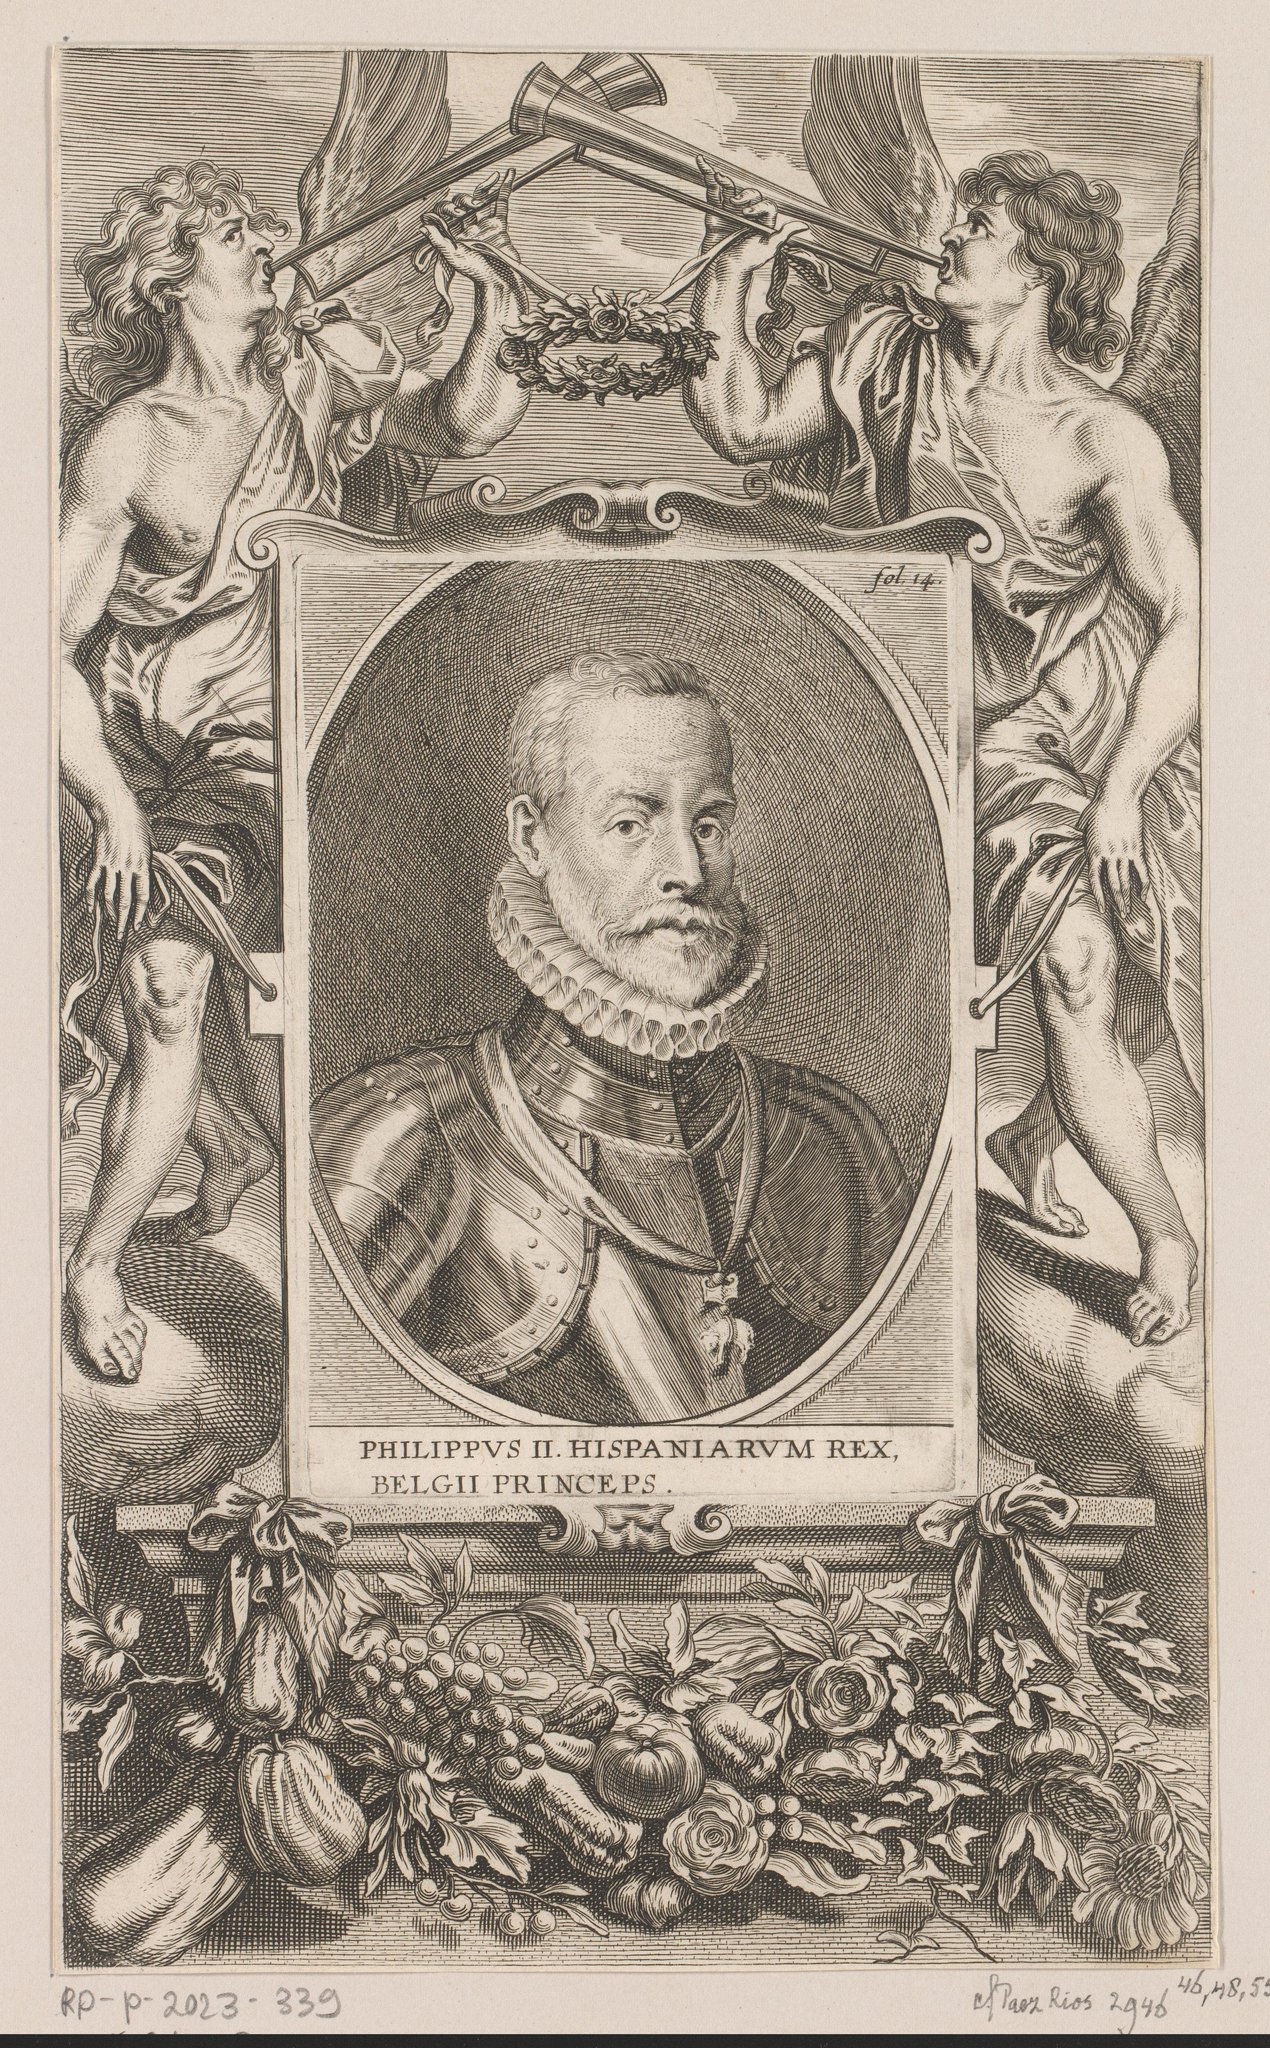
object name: book illustration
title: Portret van Filips II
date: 1640-1699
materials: paper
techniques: engraving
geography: low countries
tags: philip ii of spain, historical persons, king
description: Portret voor het eerst uitgegeven in: Strada, Famiano. De Bello Belgico. Antwerpen: Jan Cnobbaert, 1640, dl. 1. Huidige staat met vergelijkbare omlijsting komt voor in: Strada, Famiano. De thien eerste boecken der Neder-landtsche oorloghe. Antwerpen: weduwe en erfgenamen Jan Cnobbaert, 1645.